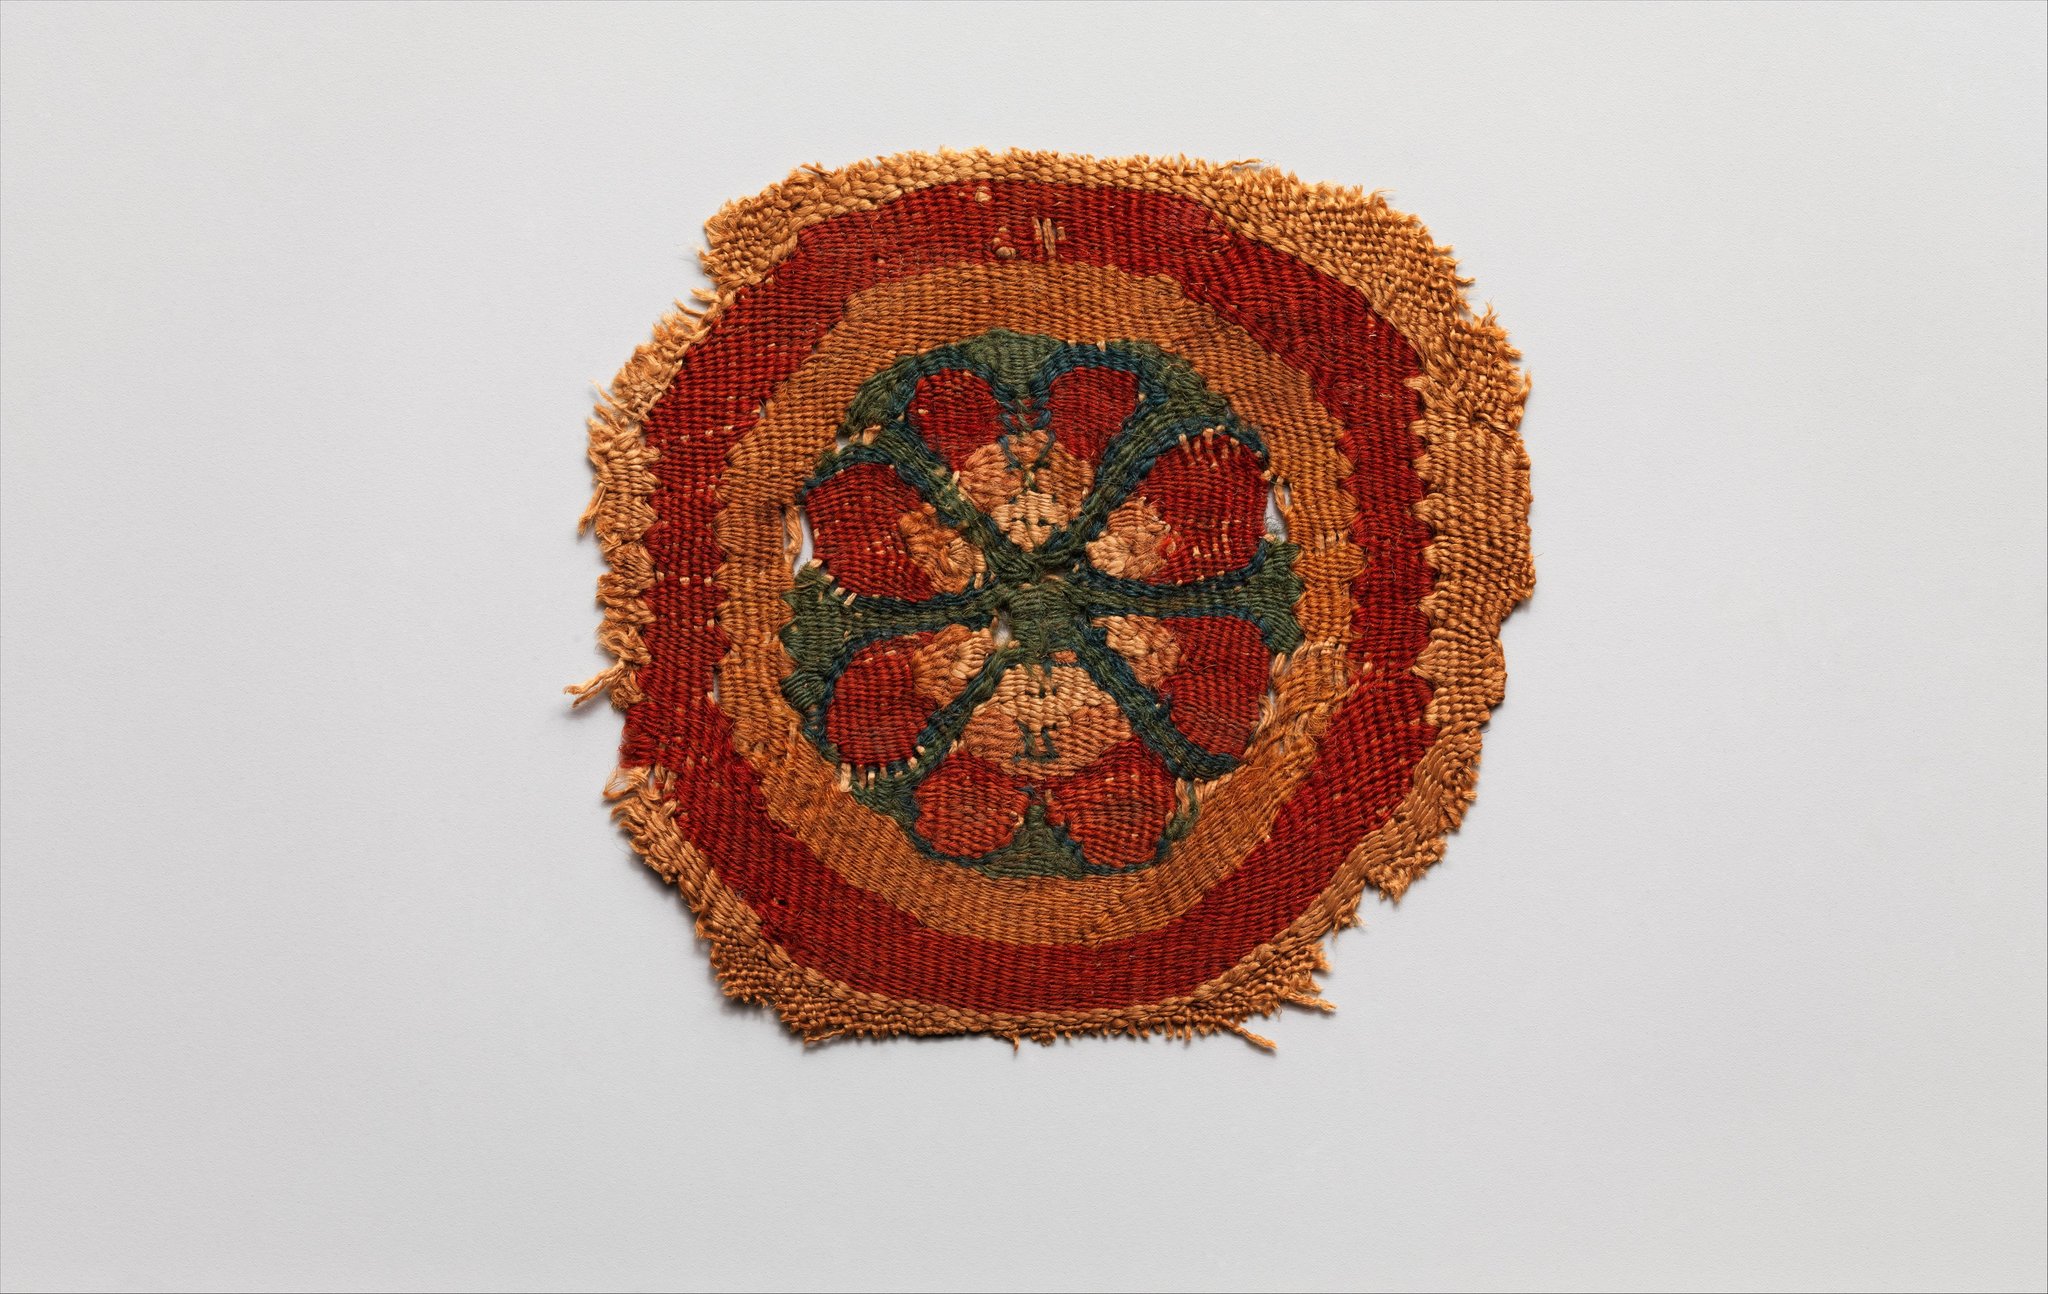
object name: textile fragment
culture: coptic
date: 501-600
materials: linen, wool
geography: egypt